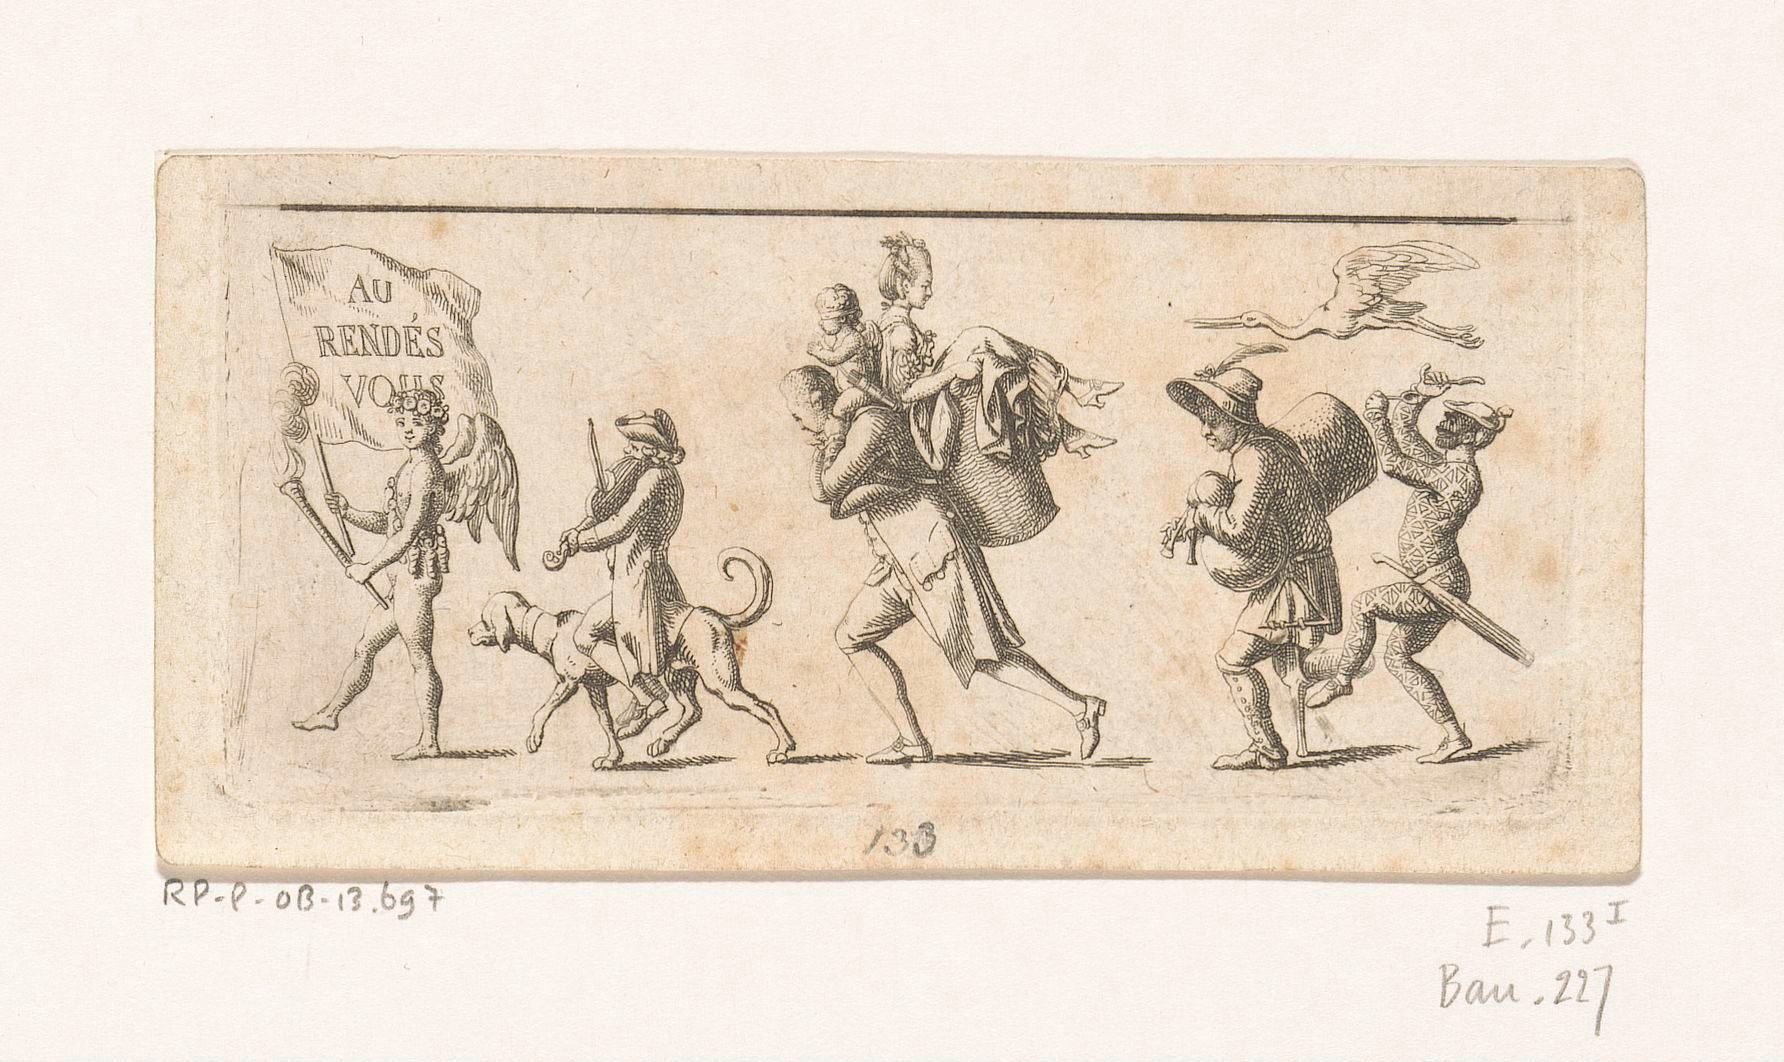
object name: print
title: Naar huis brengen van de bruid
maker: daniel nikolaus chodowiecki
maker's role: draughtsman, print maker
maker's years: 1726-1801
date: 1775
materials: paper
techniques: etching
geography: berlin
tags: (story of) hymen(aeus), animals as bringers of babies, types in 'commedia dell'arte': harlequin, (civil) marriage ceremonies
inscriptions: collector's mark: Lugt 2228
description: Bruiloftsstoet met voorop Hymen met een brandende fakkel en een vlag met daarop de tekst 'Au rendés vous', gevolgd door een violist met een hond. Daarachter de bruidegom met op zijn rug de bruid in een mand en op zijn nek een geblinddoekte amor. Daarachter een doedelzakspeler en een harlekijn. Boven de laatste figuren vliegt een ooievaar.